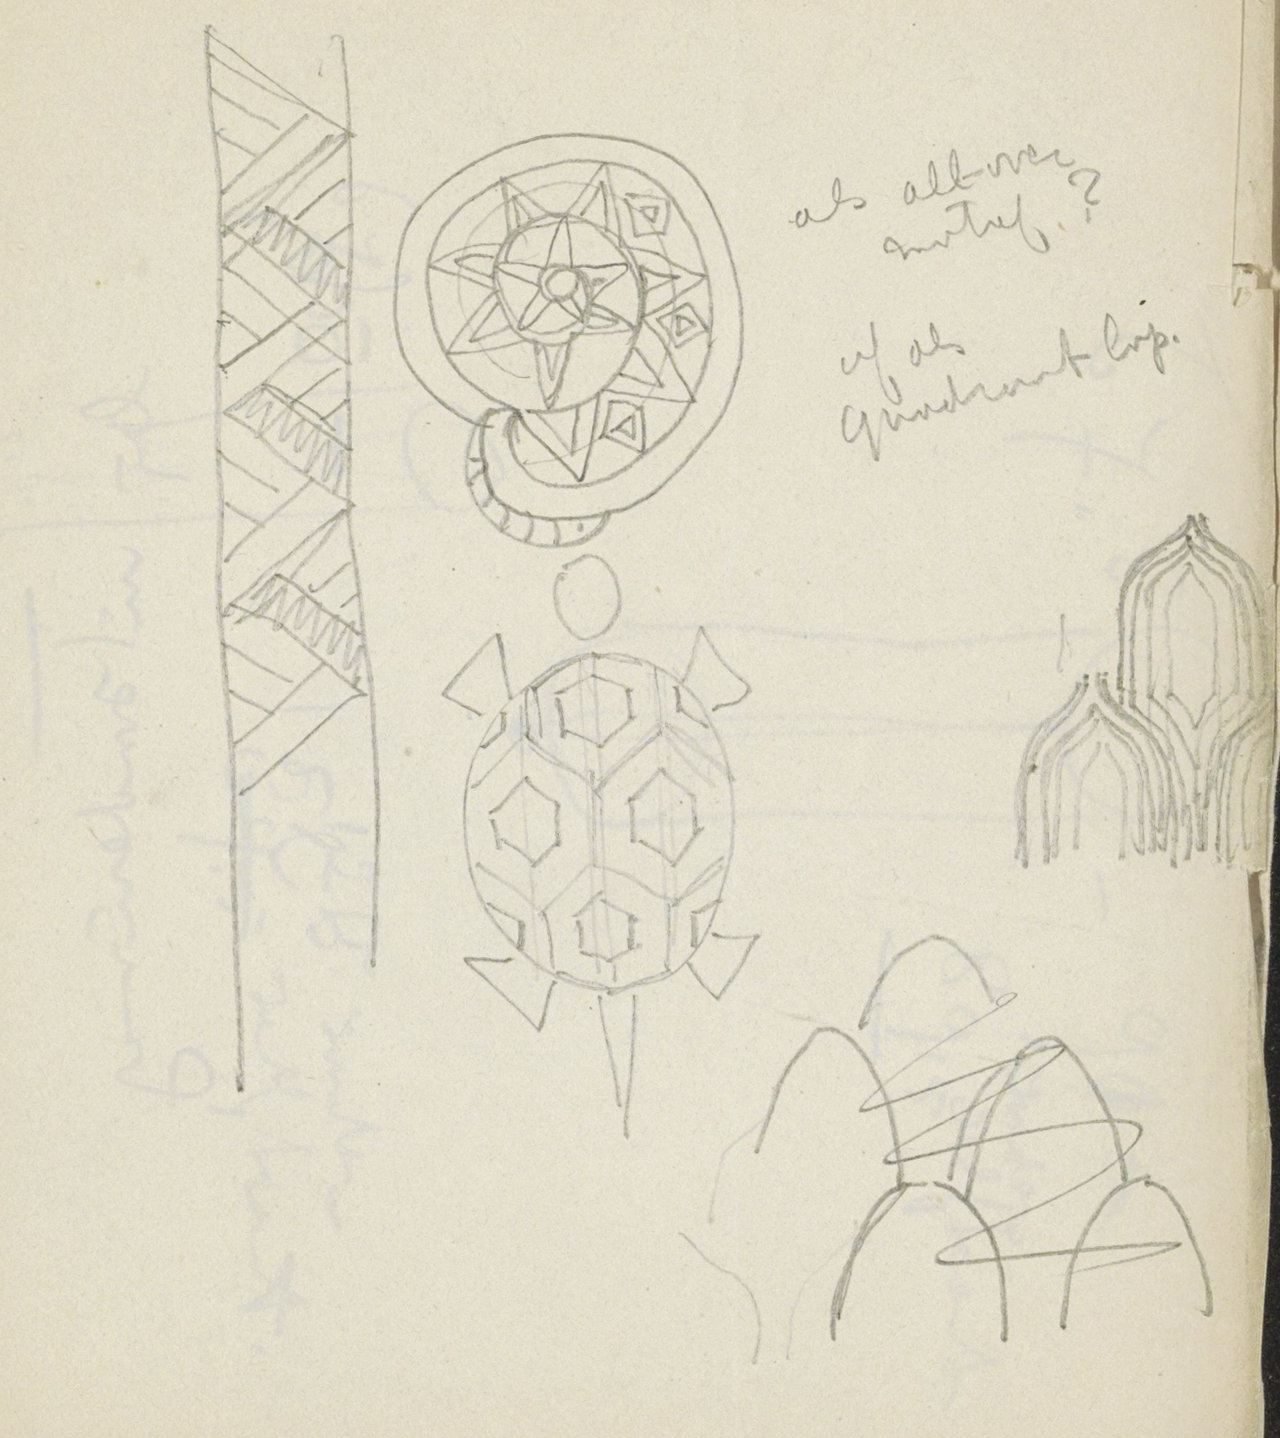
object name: sketchbook leaf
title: Decoratieve patronen en een schildpad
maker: reijer stolk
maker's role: draughtsman, print maker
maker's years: 1896-1945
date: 1916-1945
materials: paper, pencil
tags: tortoises, turtles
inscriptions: annotation: ‘als all-over/ motief?/ of als/ [...]’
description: Recto-zijde van een losse tekening tussen blad 27 verso en 28 recto uit een schetsboek met 60 bladen.